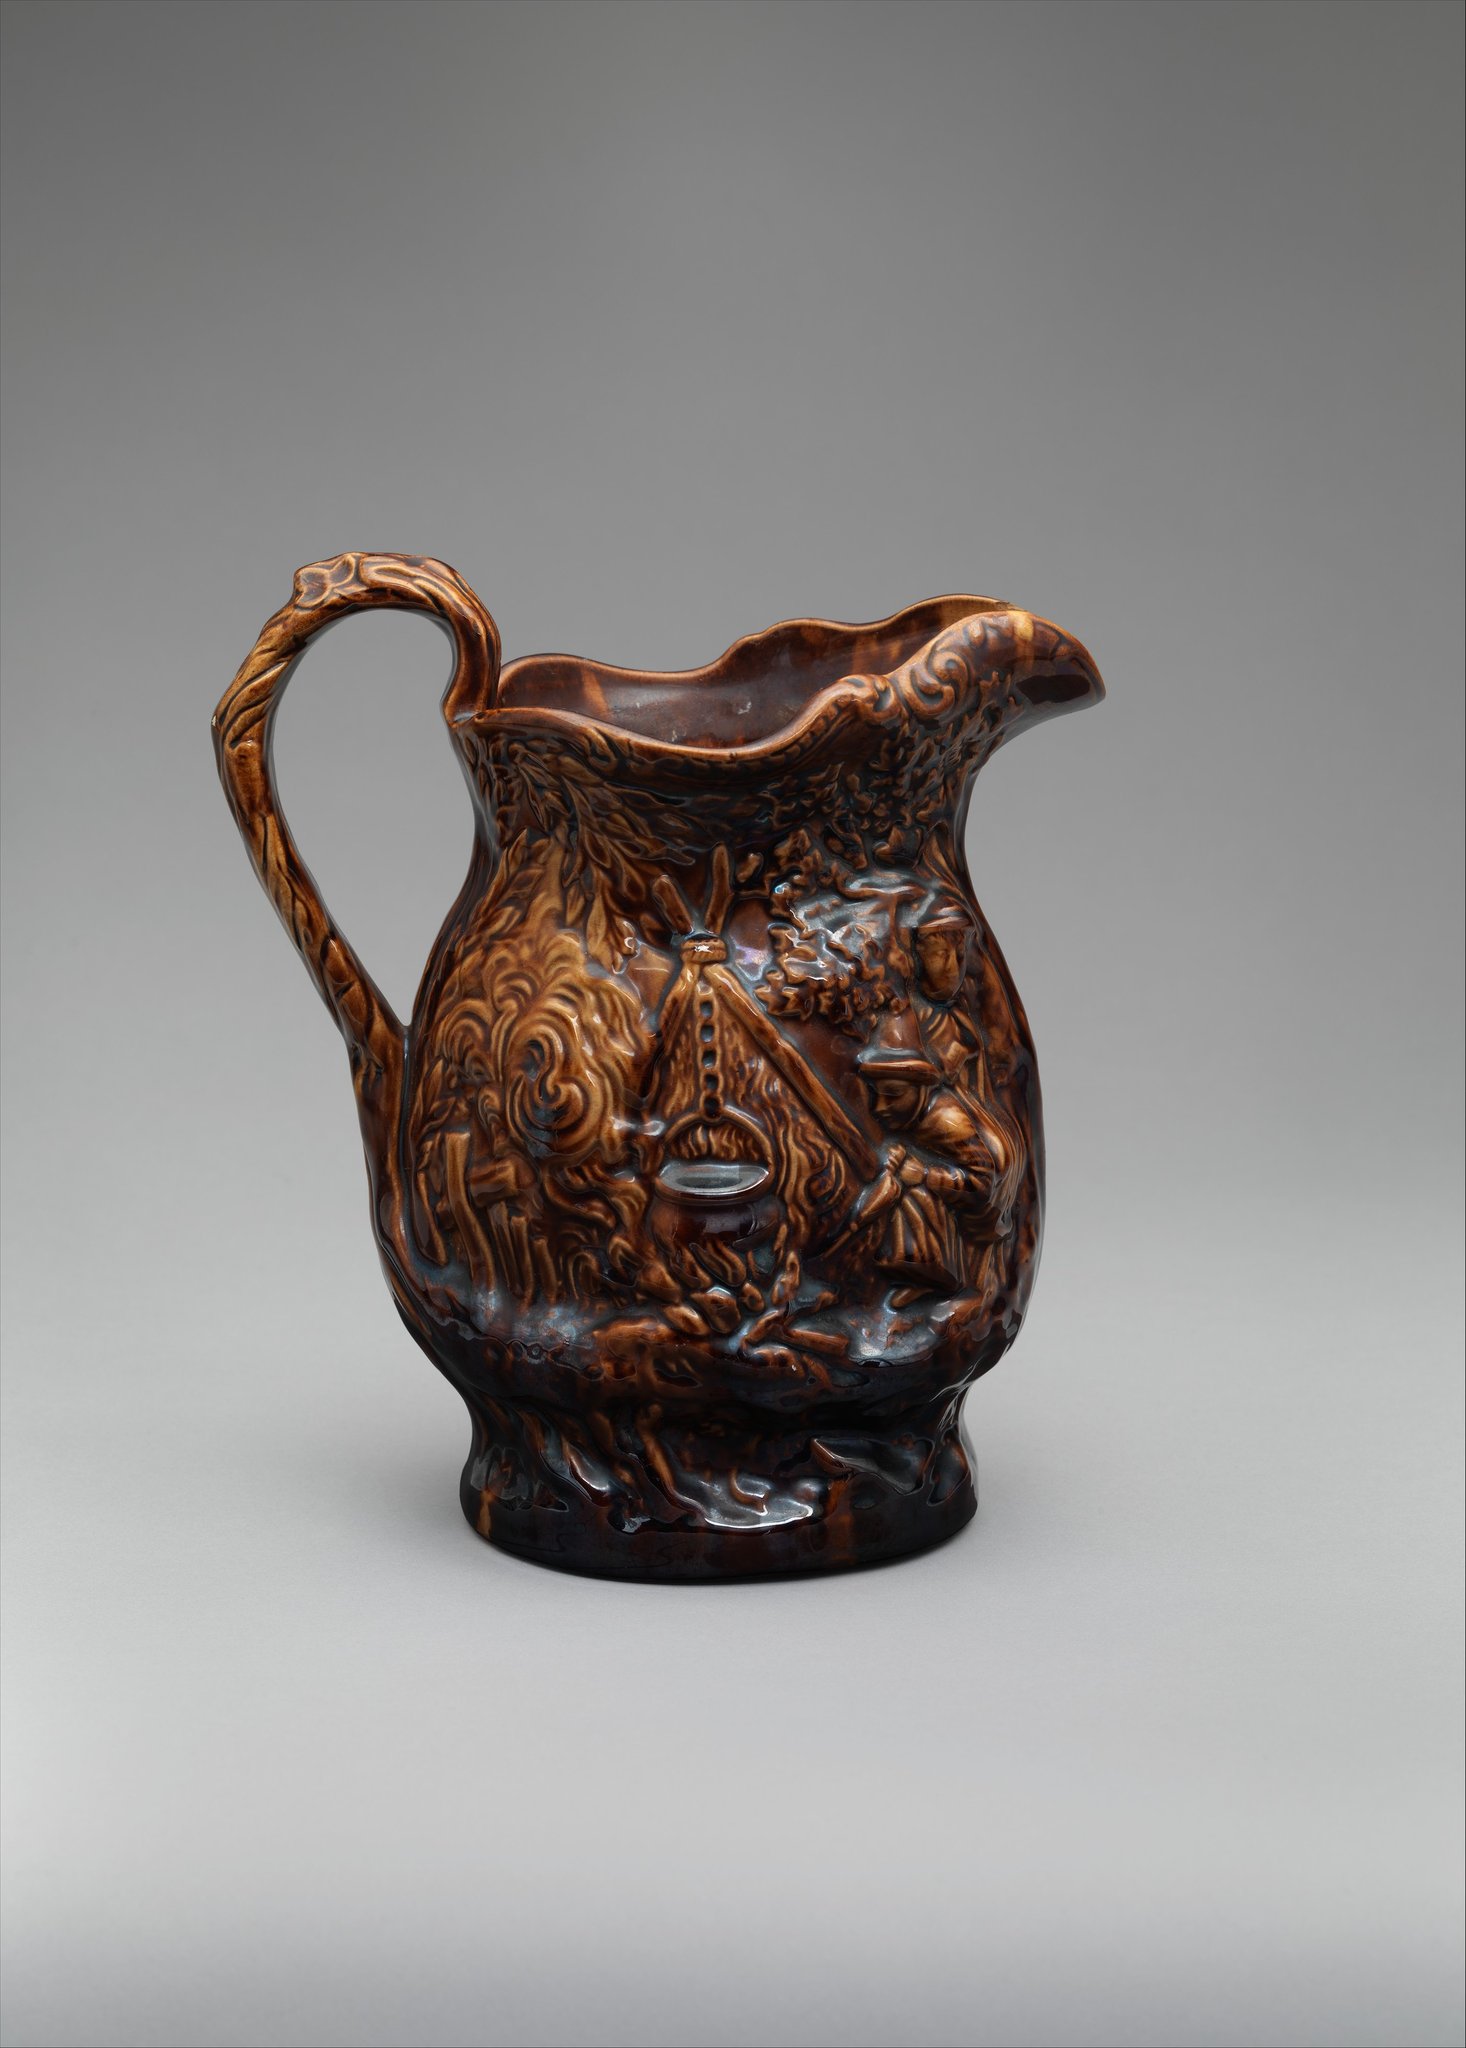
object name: pitcher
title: "Gypsy" pitcher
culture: american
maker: e. & w. bennett pottery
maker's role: manufacturer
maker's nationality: american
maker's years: 1847-1857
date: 1847-1857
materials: earthenware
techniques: casting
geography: united states